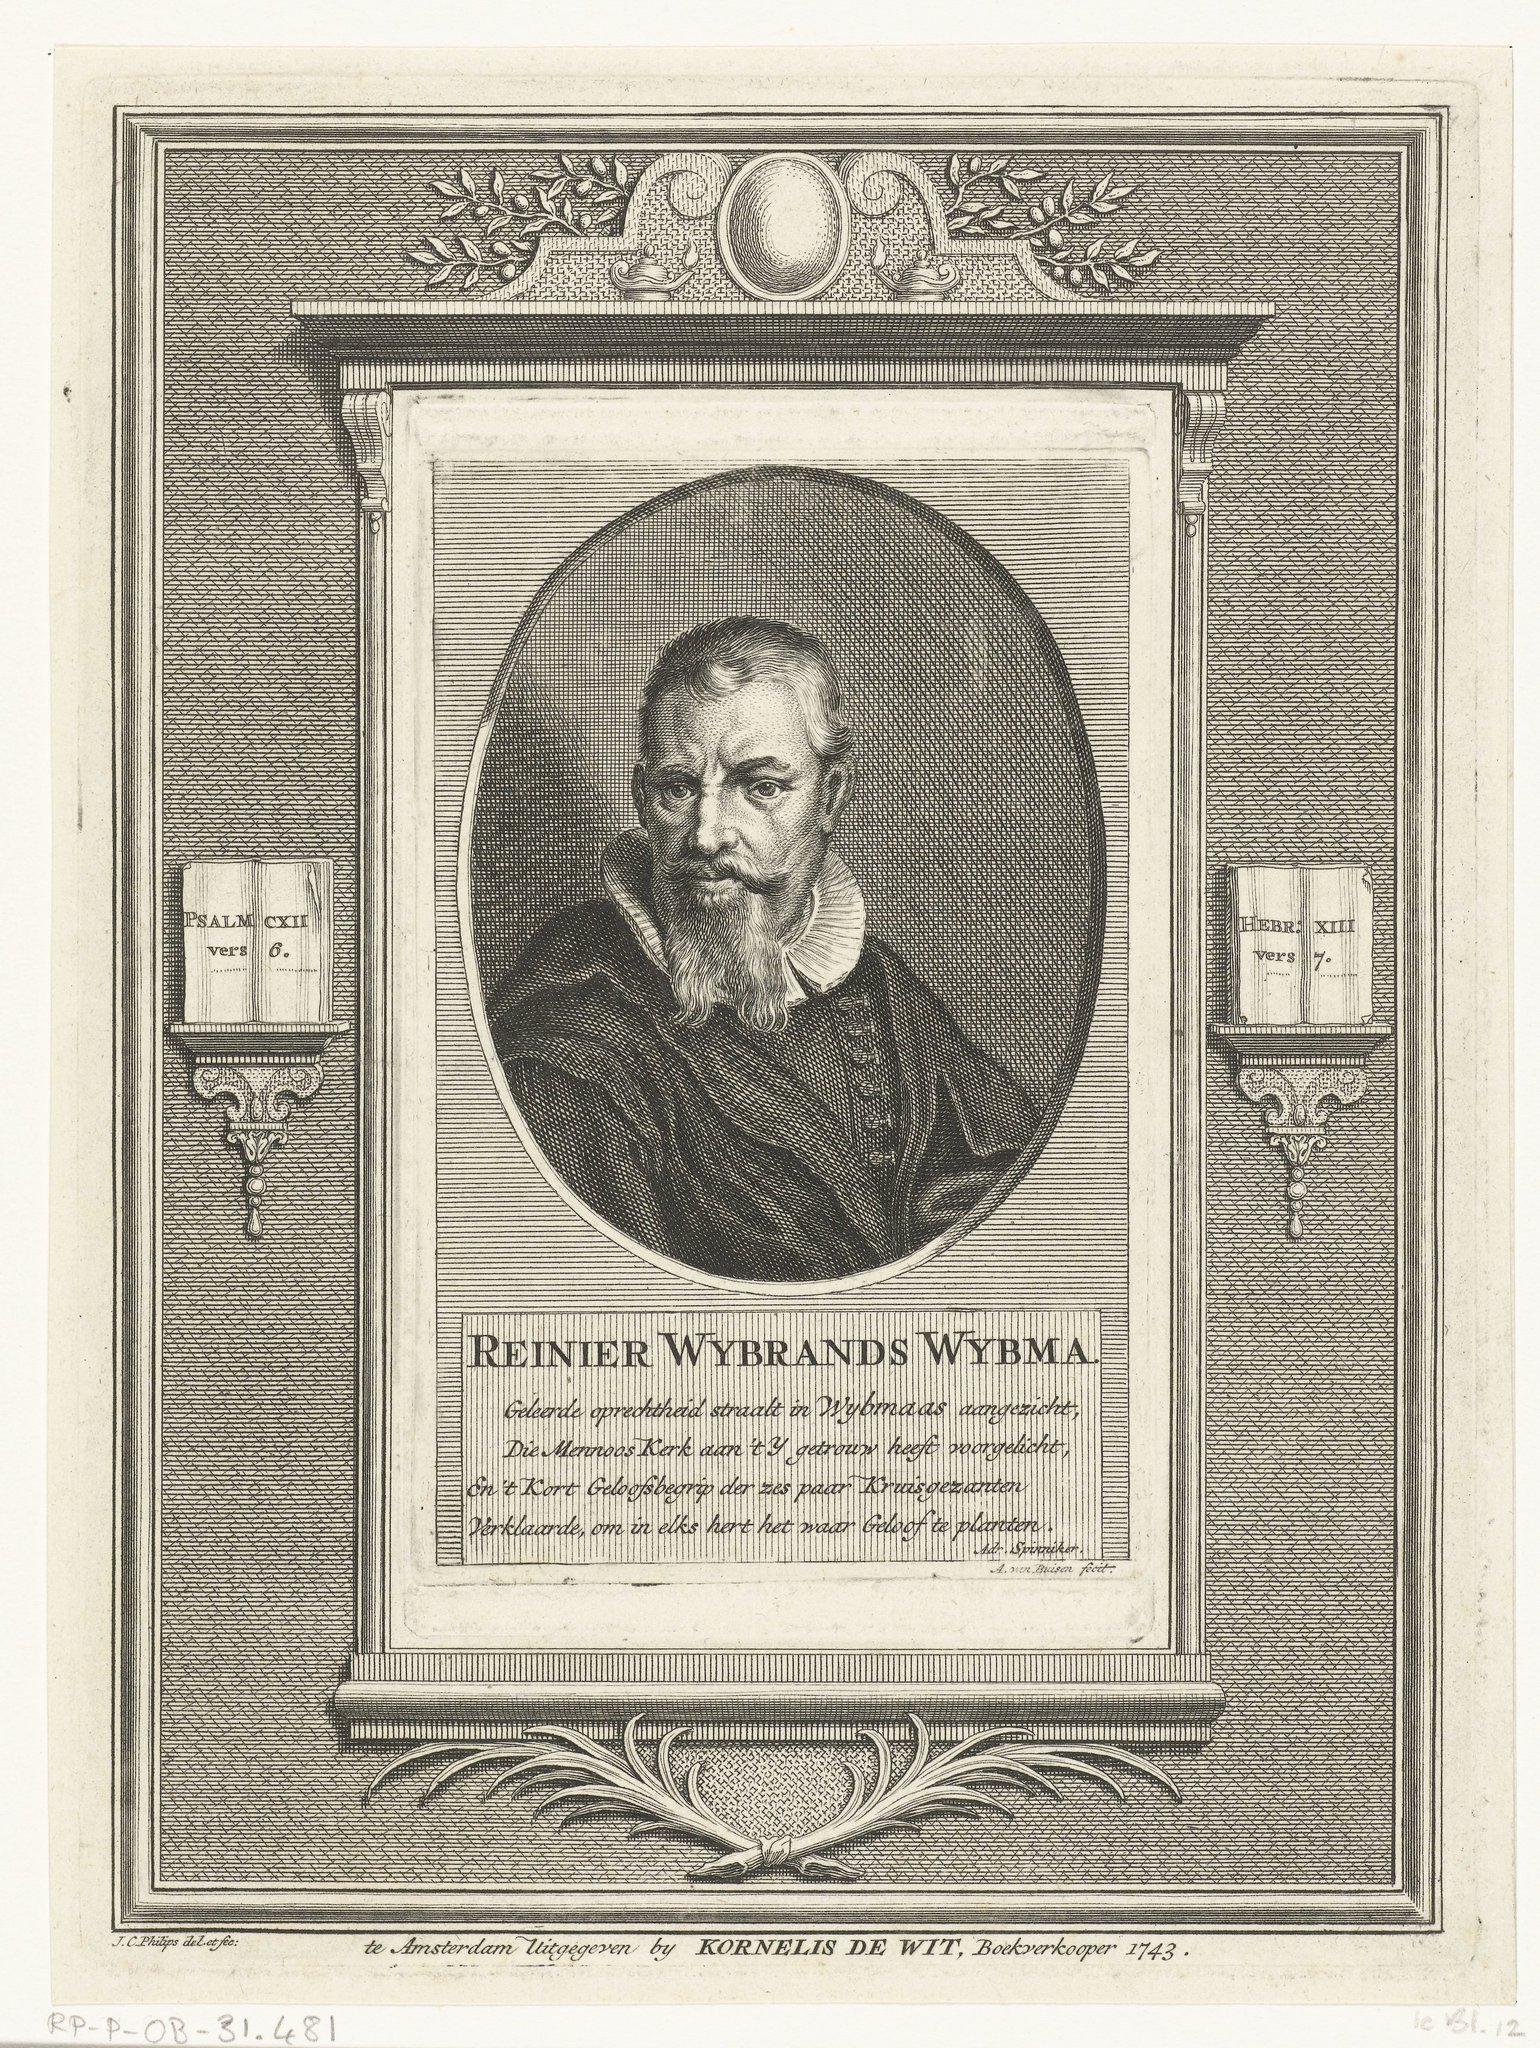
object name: print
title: Verzameling van afbeeldingen van mannen en leraren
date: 1743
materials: paper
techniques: engraving, etching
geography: amsterdam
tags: predikant, auteur, reinier wybrands wybma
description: Prent gedrukt van twee platen. Portretbuste van Reinier Wybrands Wybma, in ovaal. Onder het portret een vers van Adriaan Spinniker. Rand gedrukt van een andere plaat met verwijzingen naar bijbelverzen en met palmbladeren versierd.